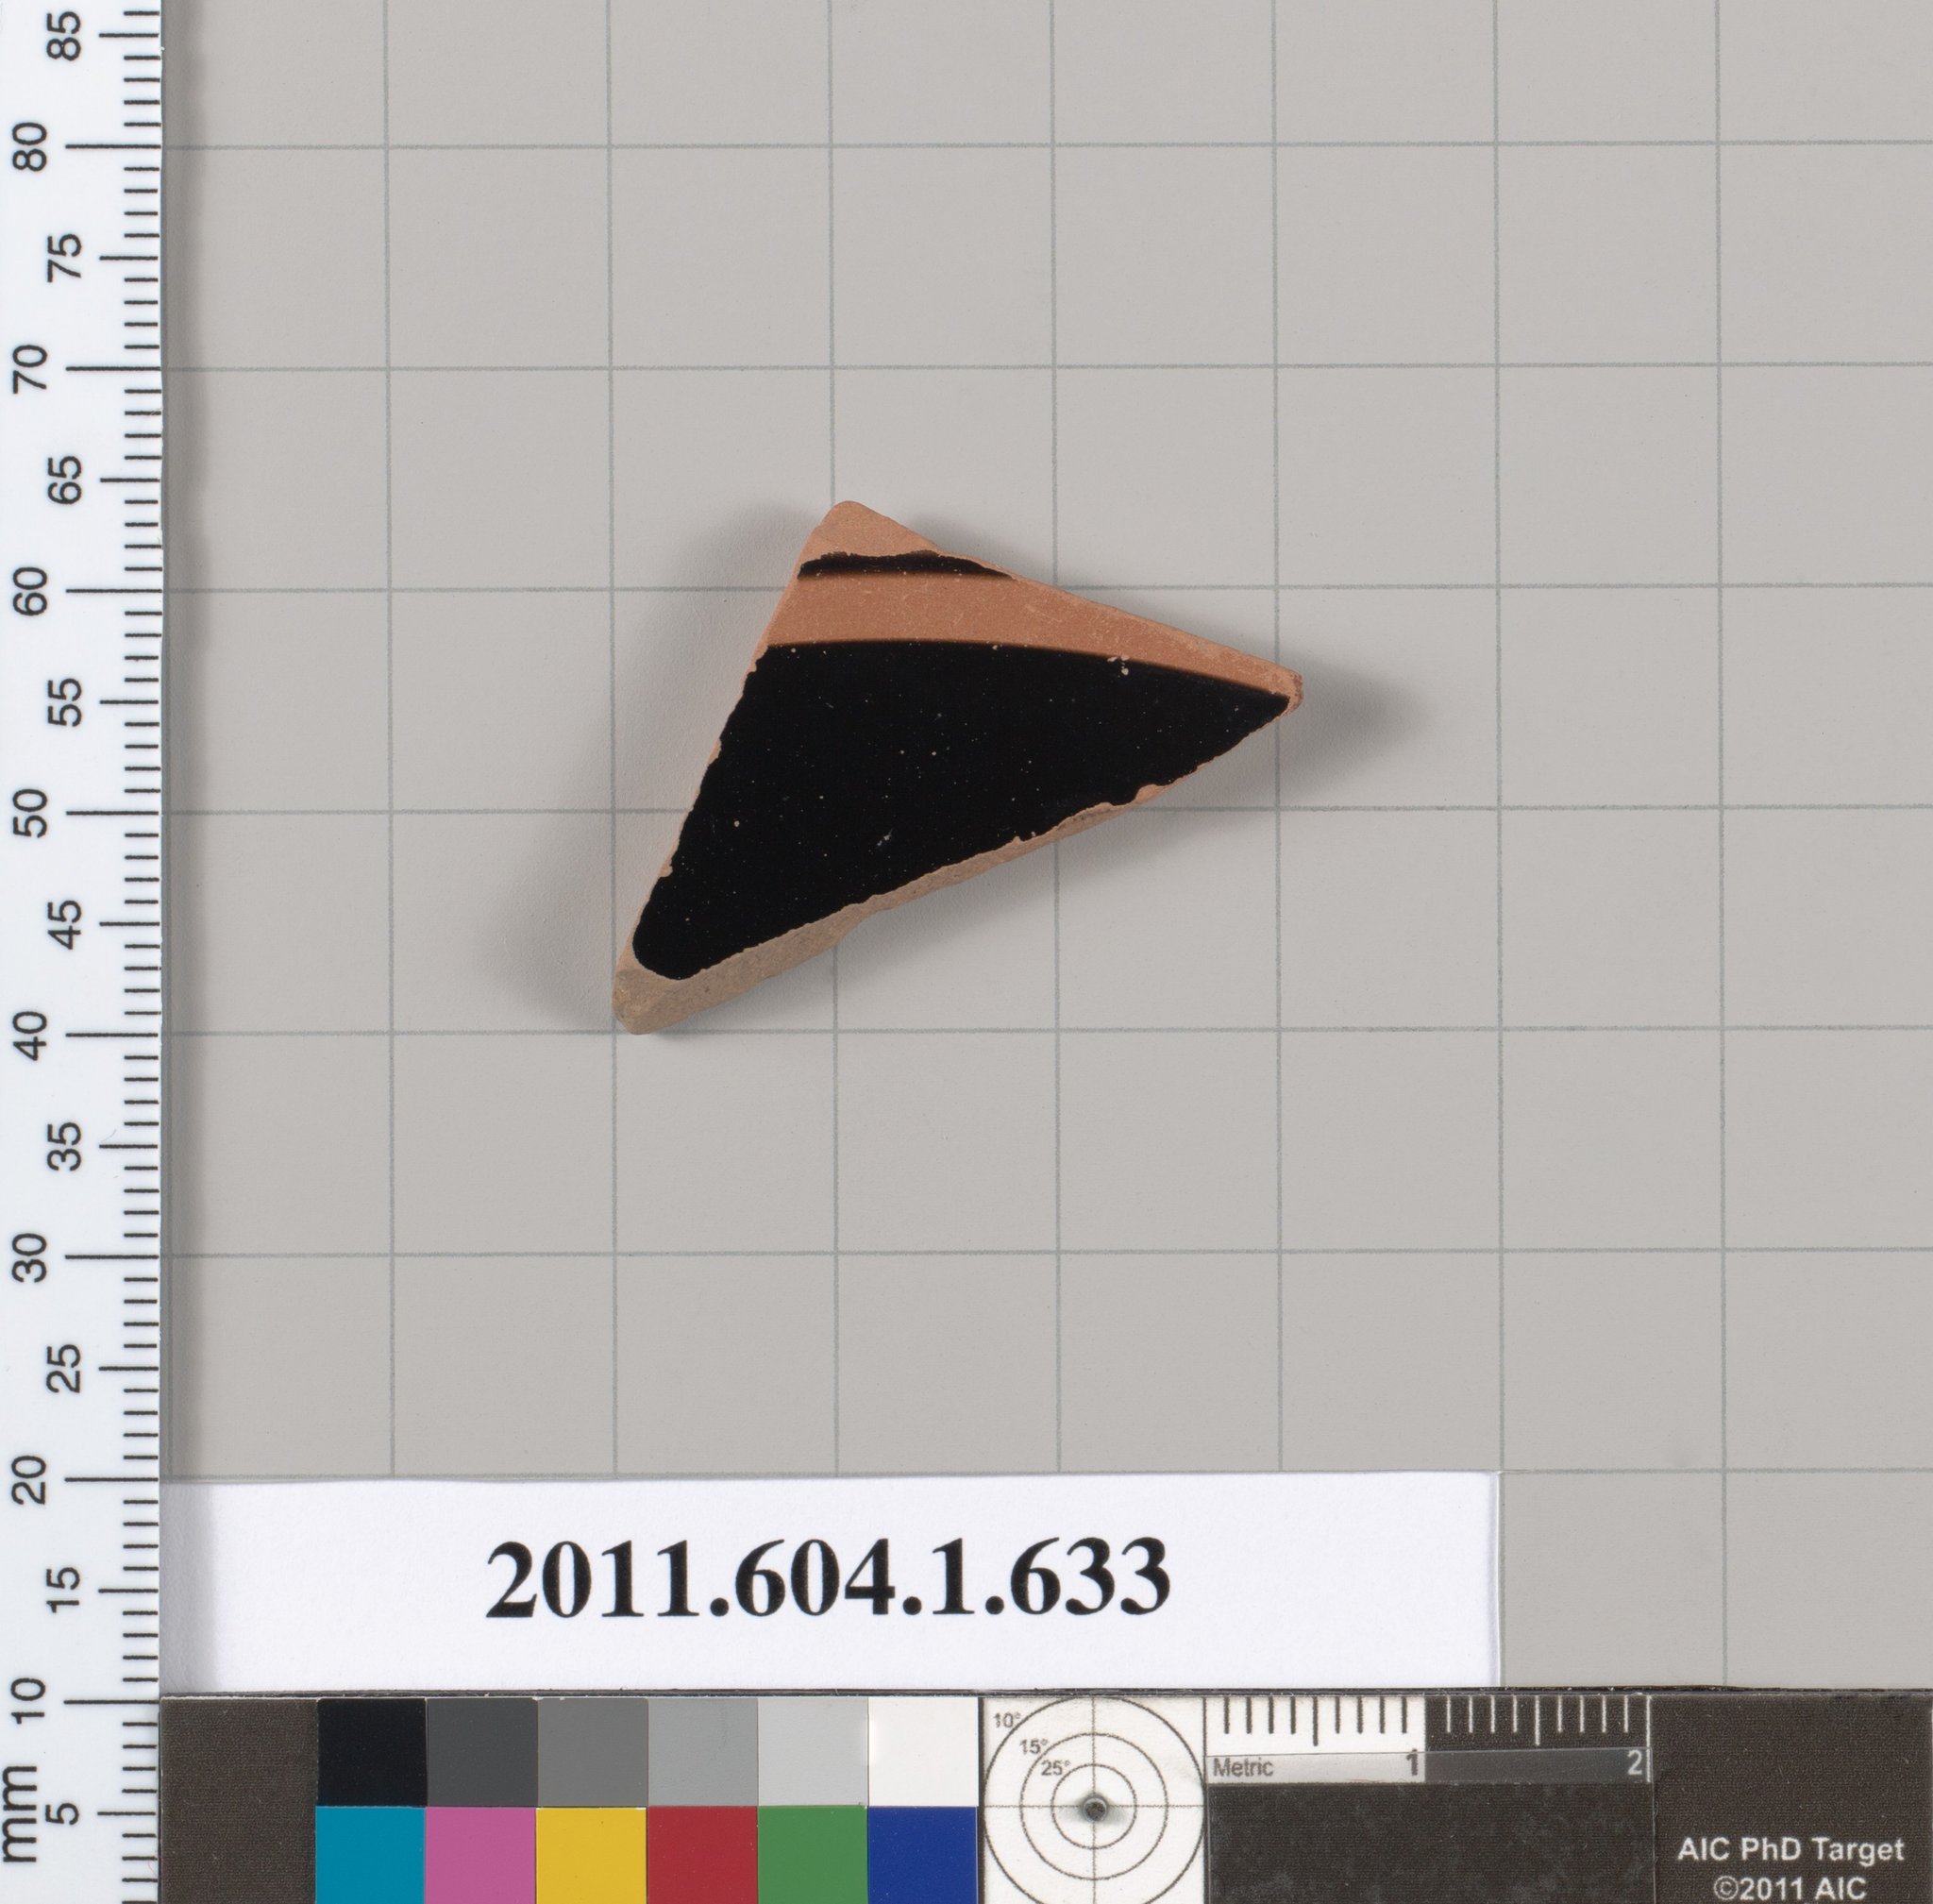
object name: kylix fragment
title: Terracotta fragment of a kylix (drinking cup)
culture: greek, attic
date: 475-451 BCE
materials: terracotta